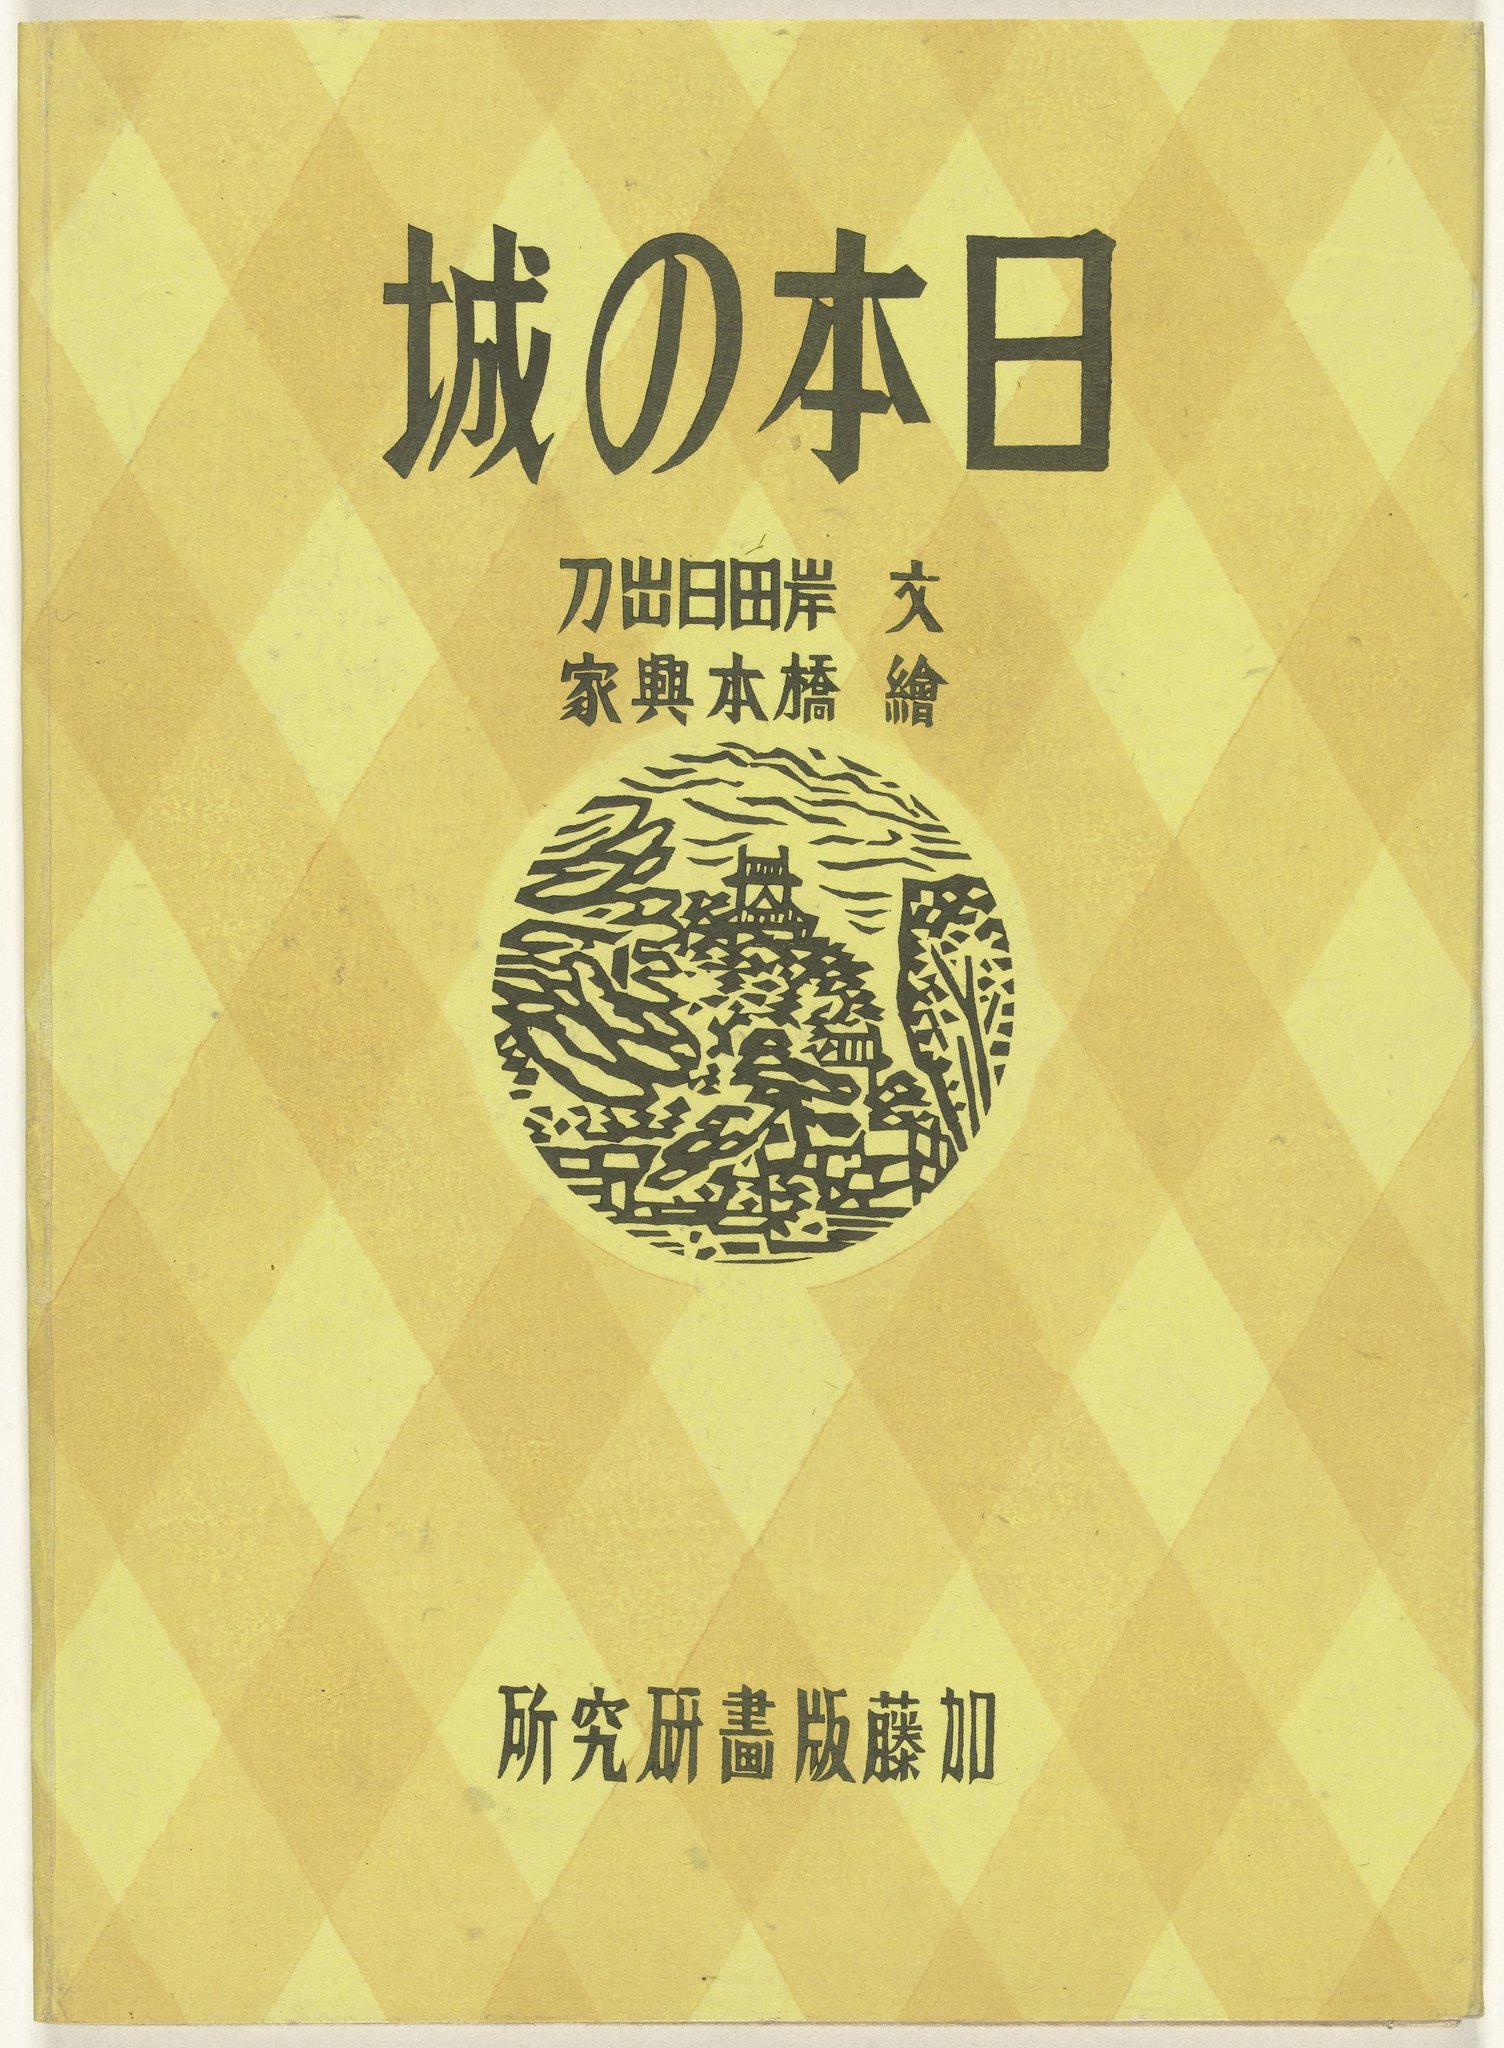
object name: book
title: Nihon no shiro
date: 1906-1944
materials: paper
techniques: woodcut, letterpress printing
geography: japan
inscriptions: date